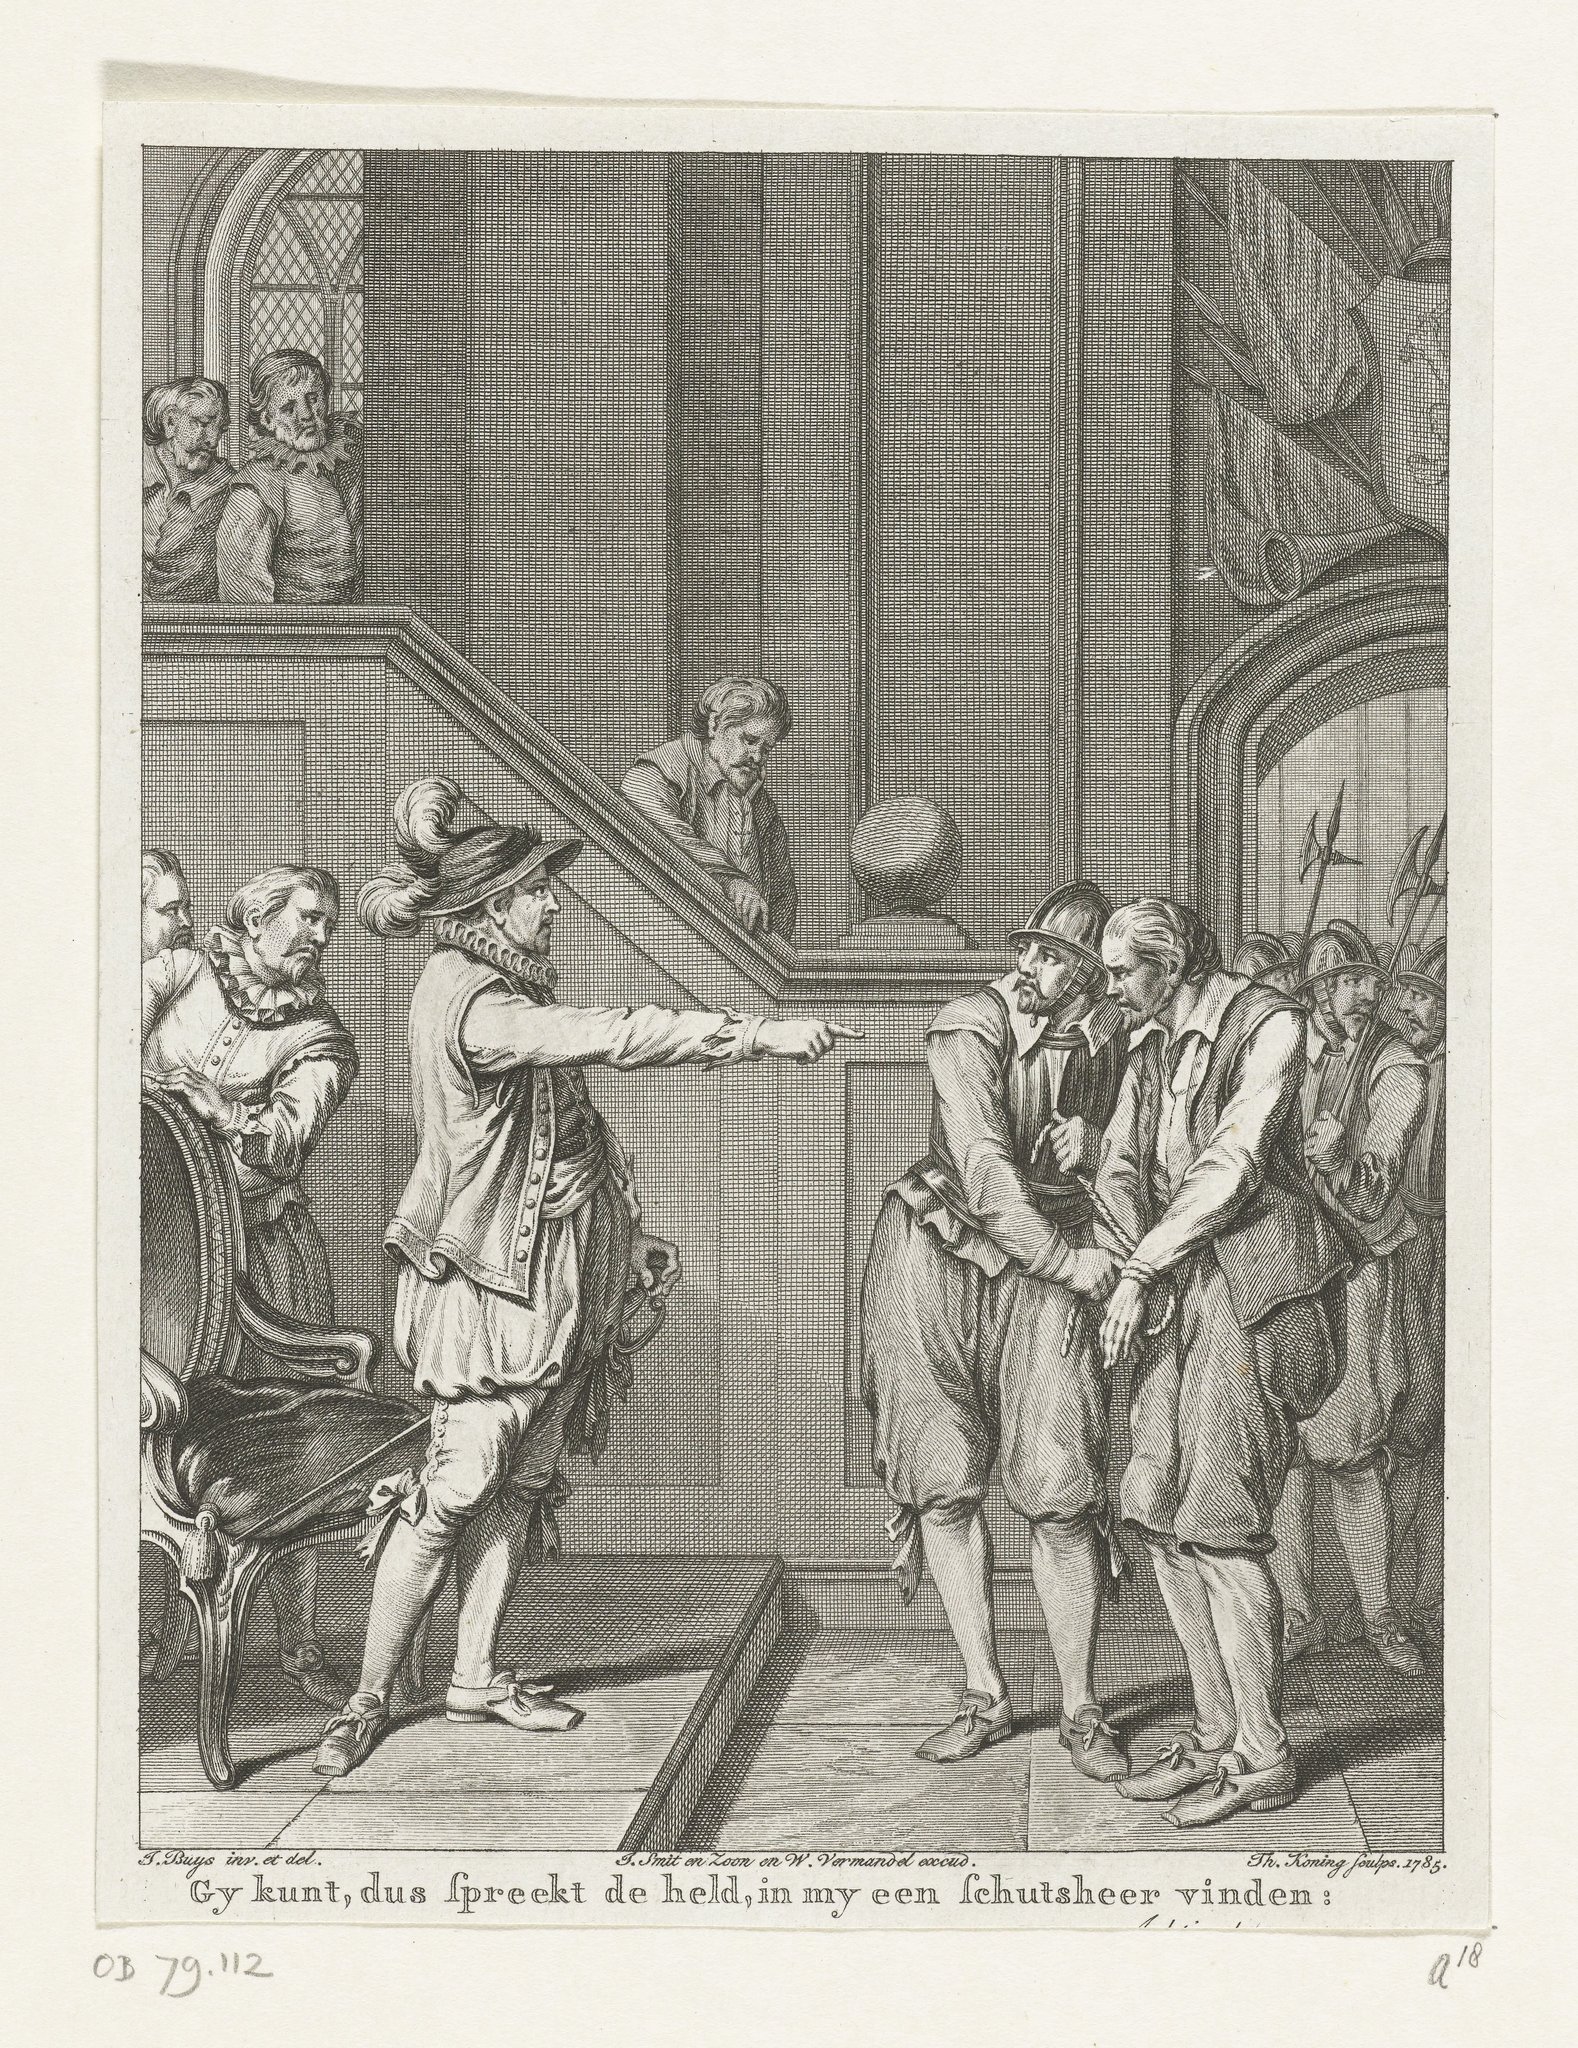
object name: print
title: Taferelen uit het leven van prins Willem I, 1568-1584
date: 1785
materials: paper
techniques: etching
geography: amsterdam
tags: william i (prince of orange), don juan van oostenrijk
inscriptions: date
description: Illustratie voor: J. Nomsz, Willem de eerste, of de grondlegging der Nederlandsche vryheid. : In vier en twintig zangen, Erven van David Klippink, Amsterdam 1779. Staat met de letter.